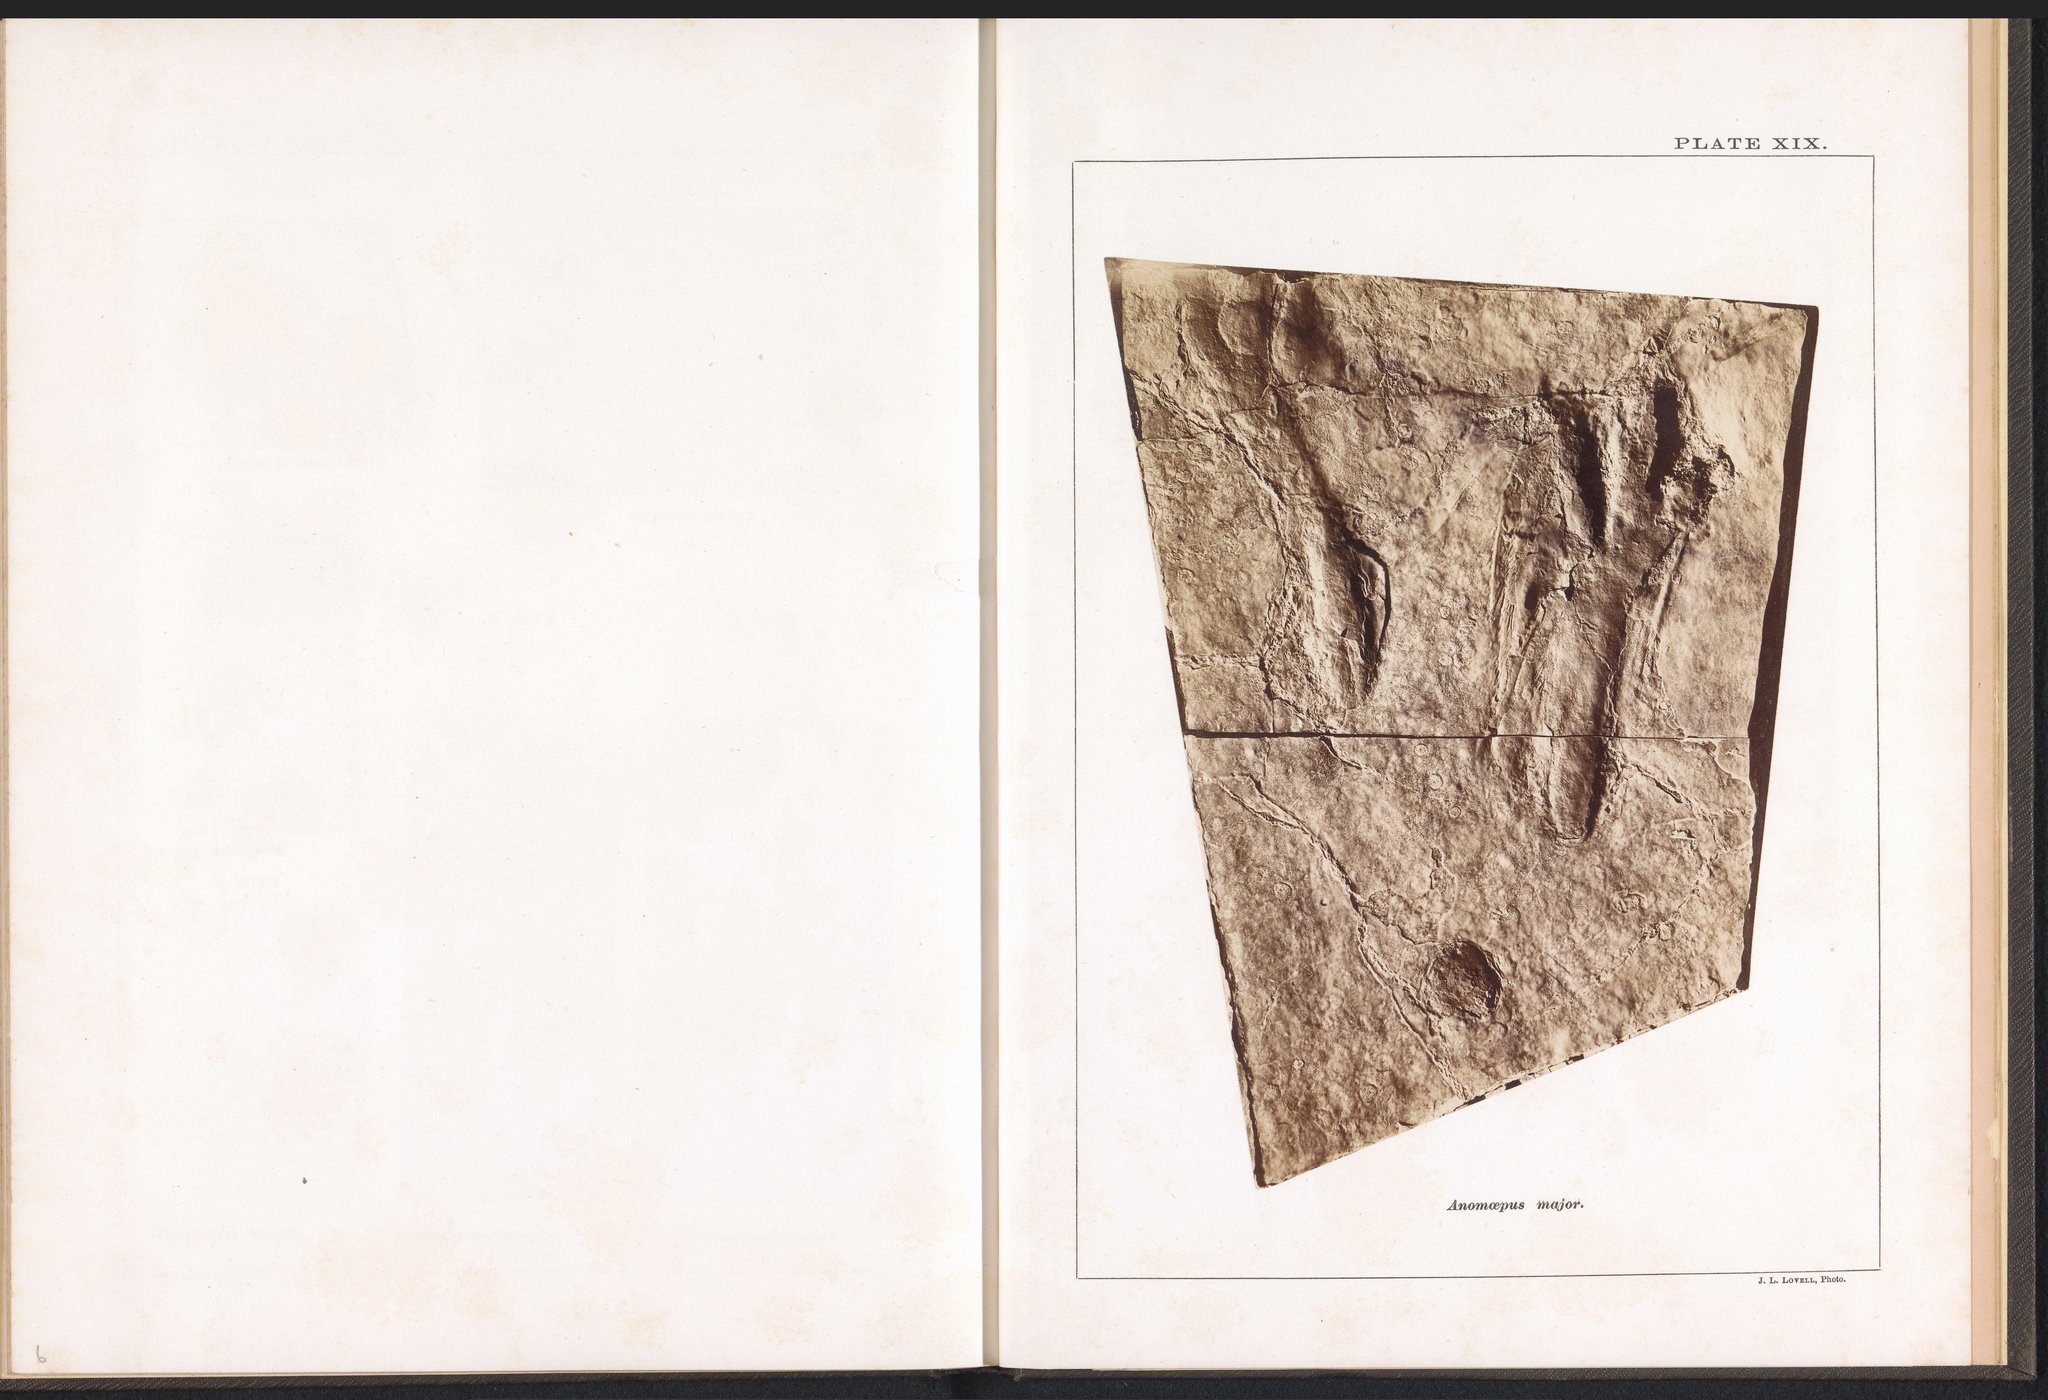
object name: photograph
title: Anomæpus major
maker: j.l. lovell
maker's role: fotograaf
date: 1858-1863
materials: photographic support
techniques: albumen print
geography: amherst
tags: foot-print, track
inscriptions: number: ‘Plate XIX.’